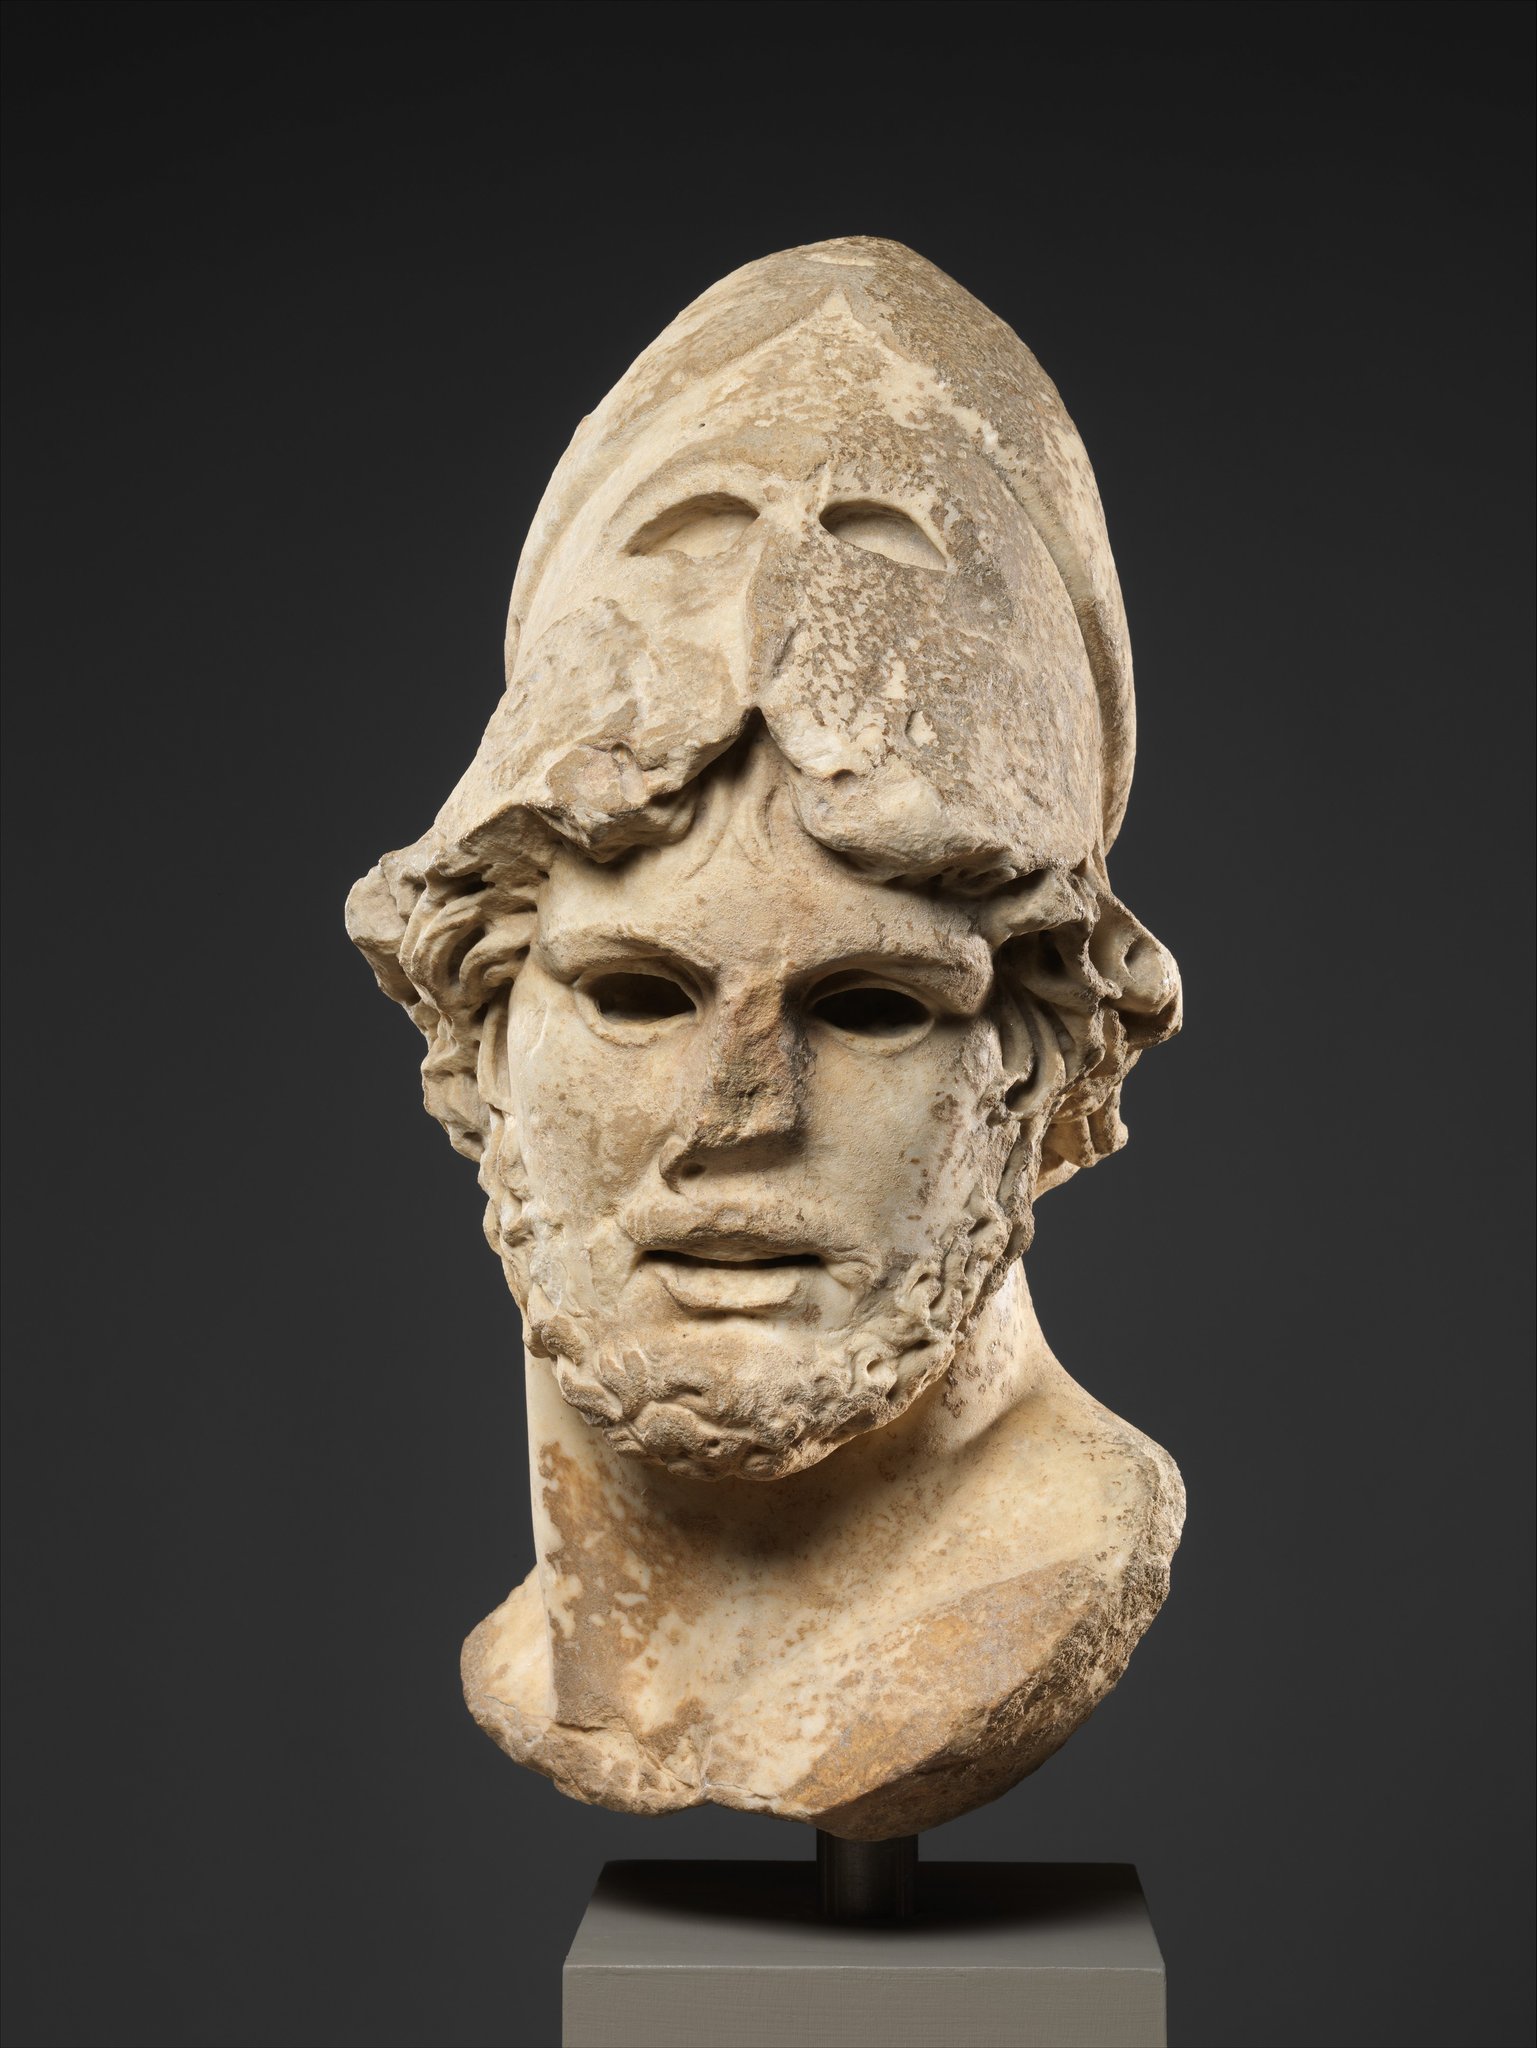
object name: head of a general strategos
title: Marble head of a Greek general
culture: roman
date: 1-200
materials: marble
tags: heads,men,generals